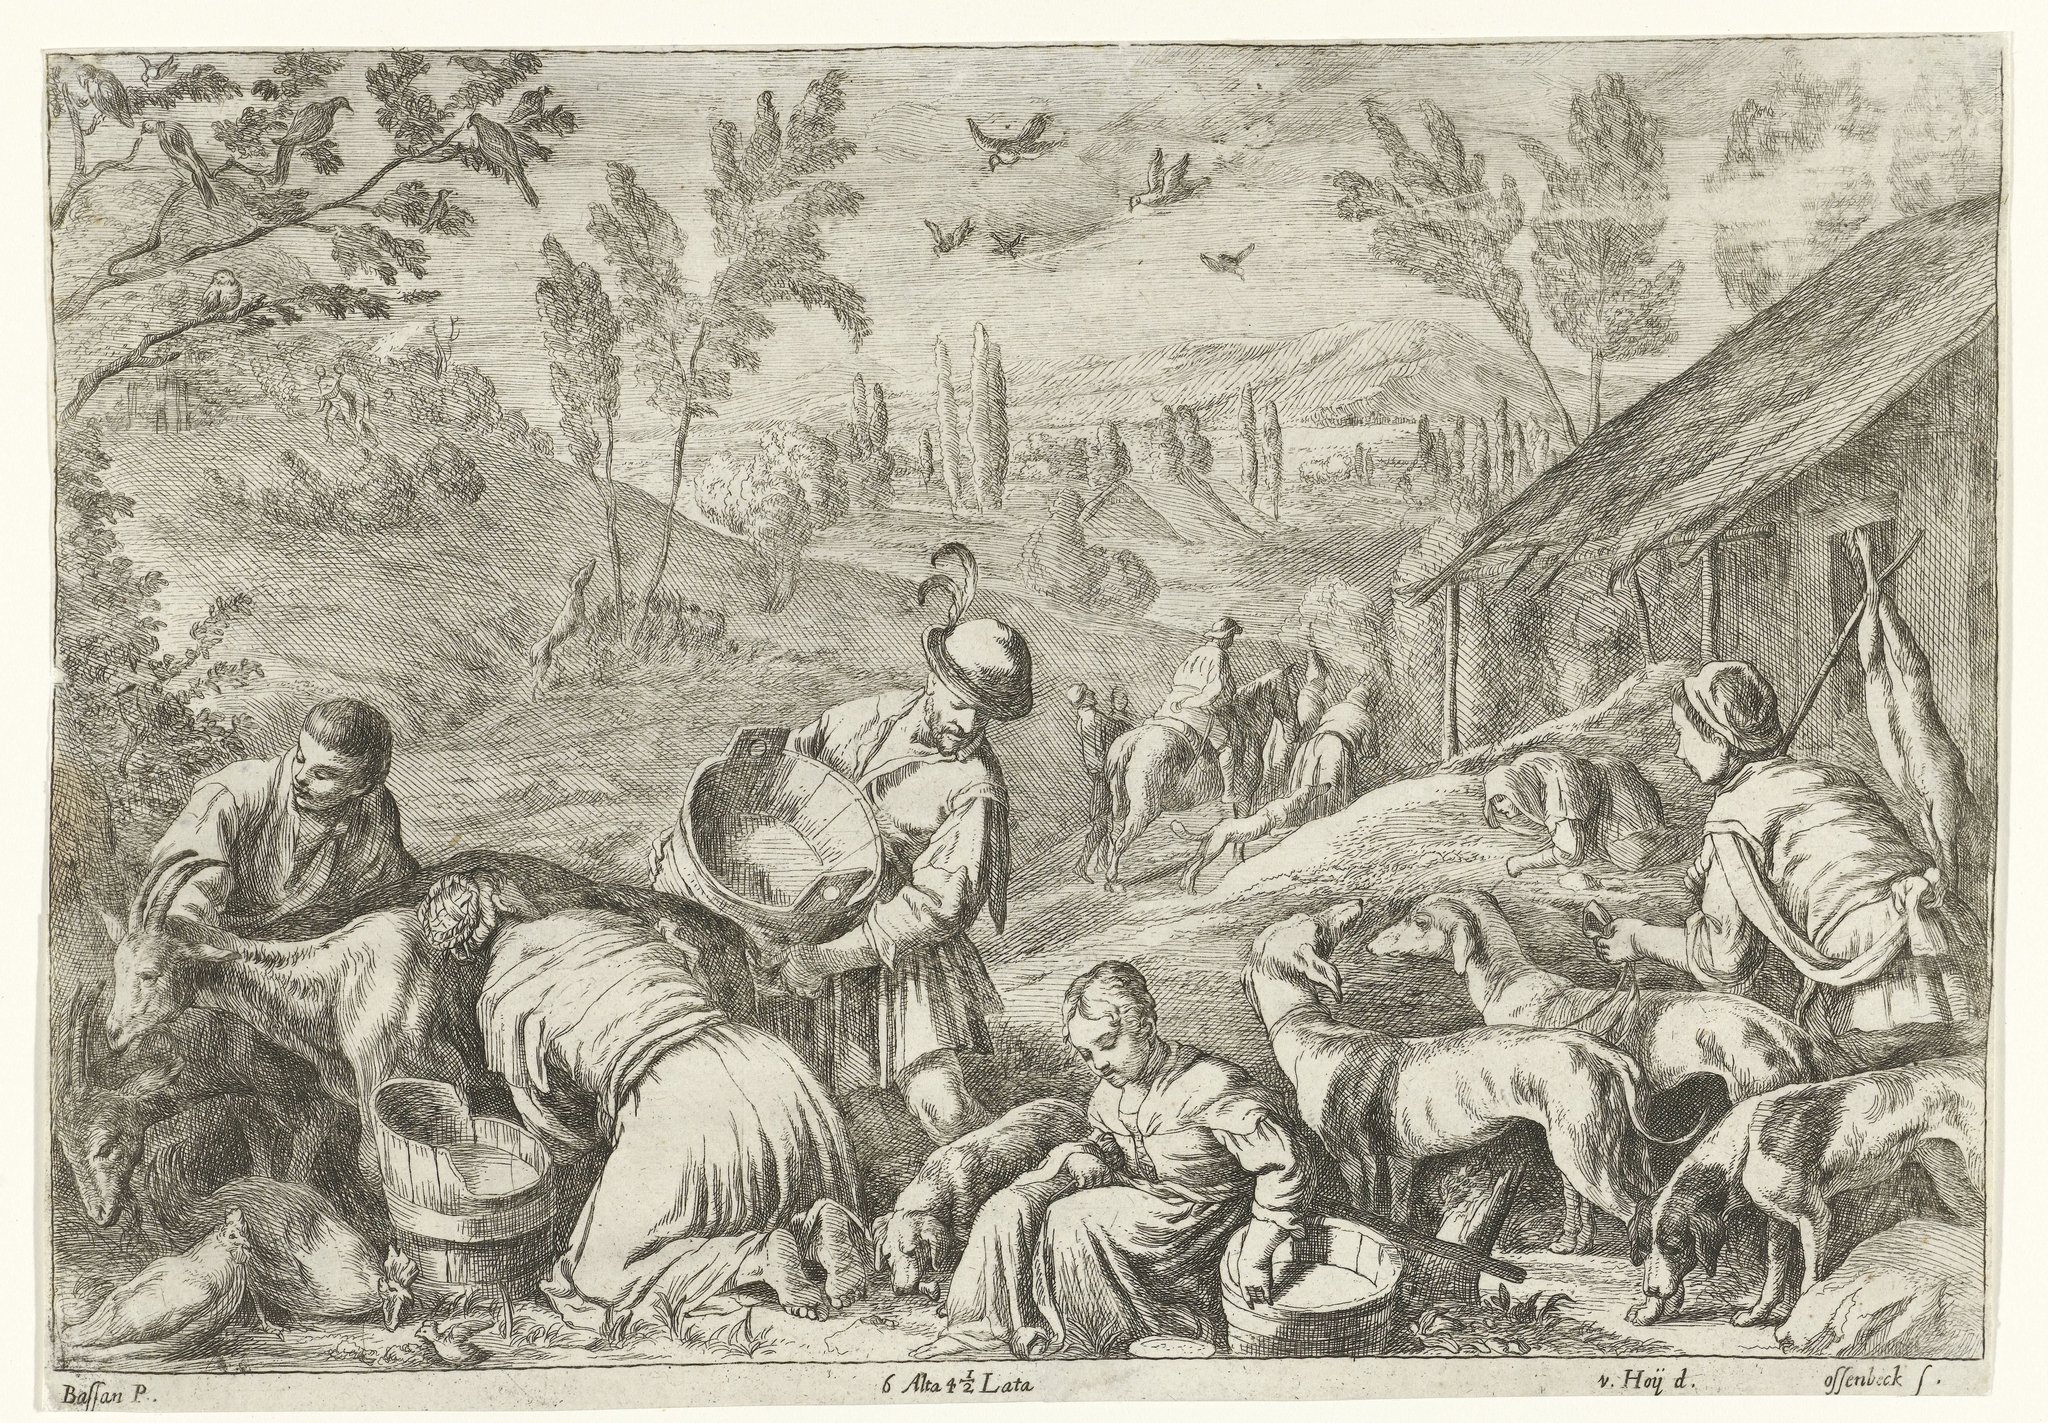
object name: print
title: De vier seizoenen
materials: paper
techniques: engraving, etching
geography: brussels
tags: spring landscape; landscape symbolizing spring (the four seasons of the year)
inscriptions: collector's mark: Lugt 2228, collector's mark: Lugt 345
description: Een groepje boeren aan het werk buiten hun huis. Een vrouw melkt de geiten. Een man draagt een tobbe met melk. Rechts een jongen met zijn honden, hij draagt een dode haas op zijn schouder. Voorstelling van de lente in een serie met prenten van de vier seizoenen.